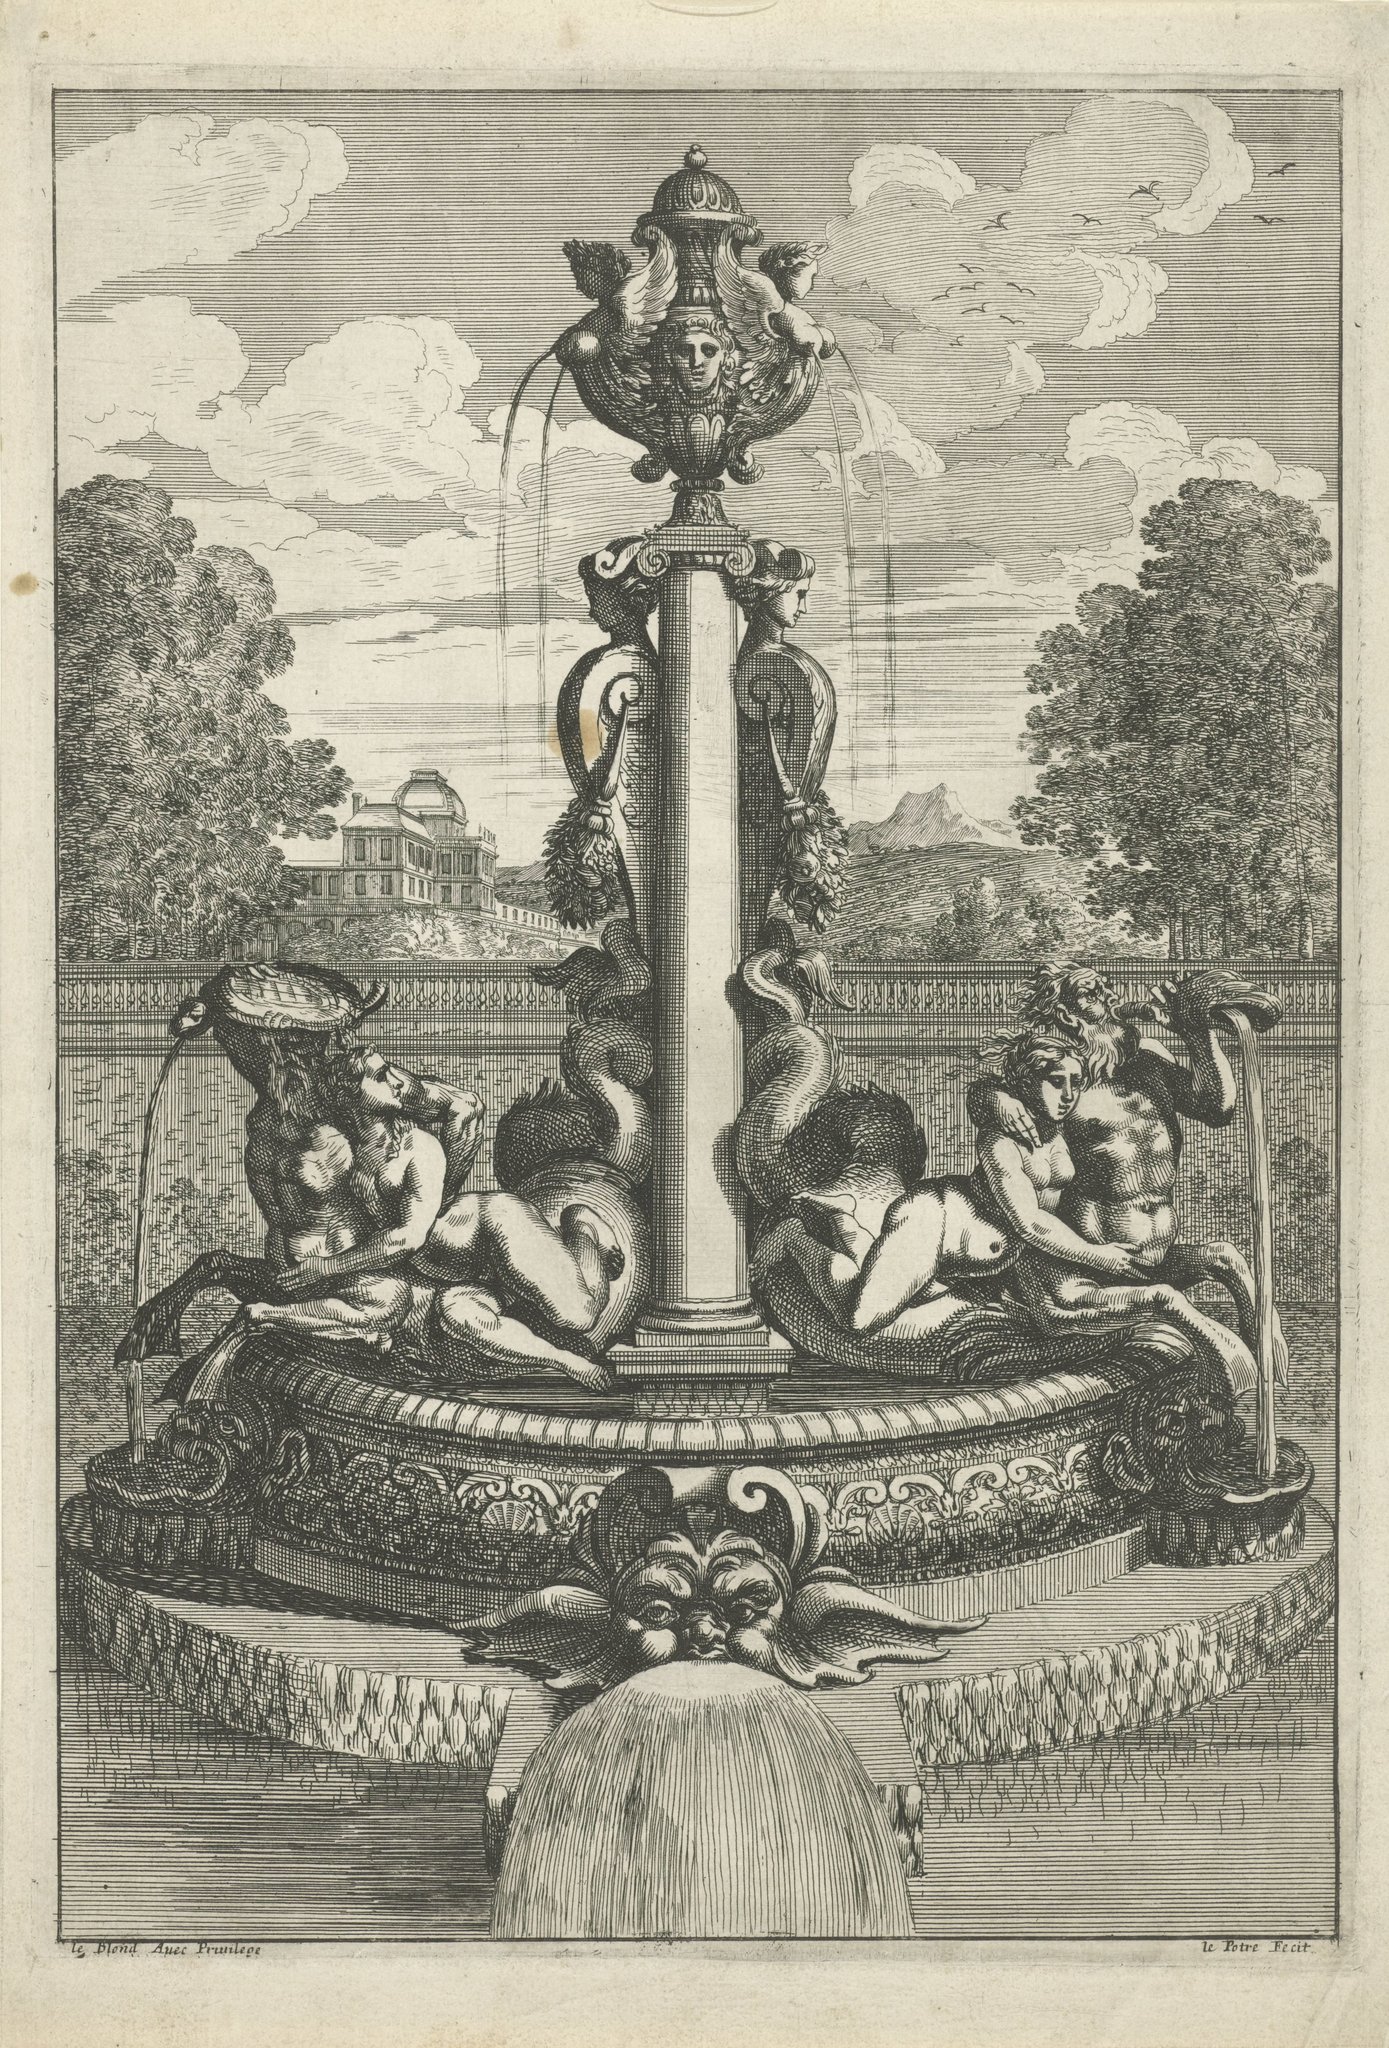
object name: ornament print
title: Grote fonteinen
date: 1665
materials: paper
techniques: etching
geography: paris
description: Aan weerszijden van de zuil staan twee hermen en bovenop staat een vaas.